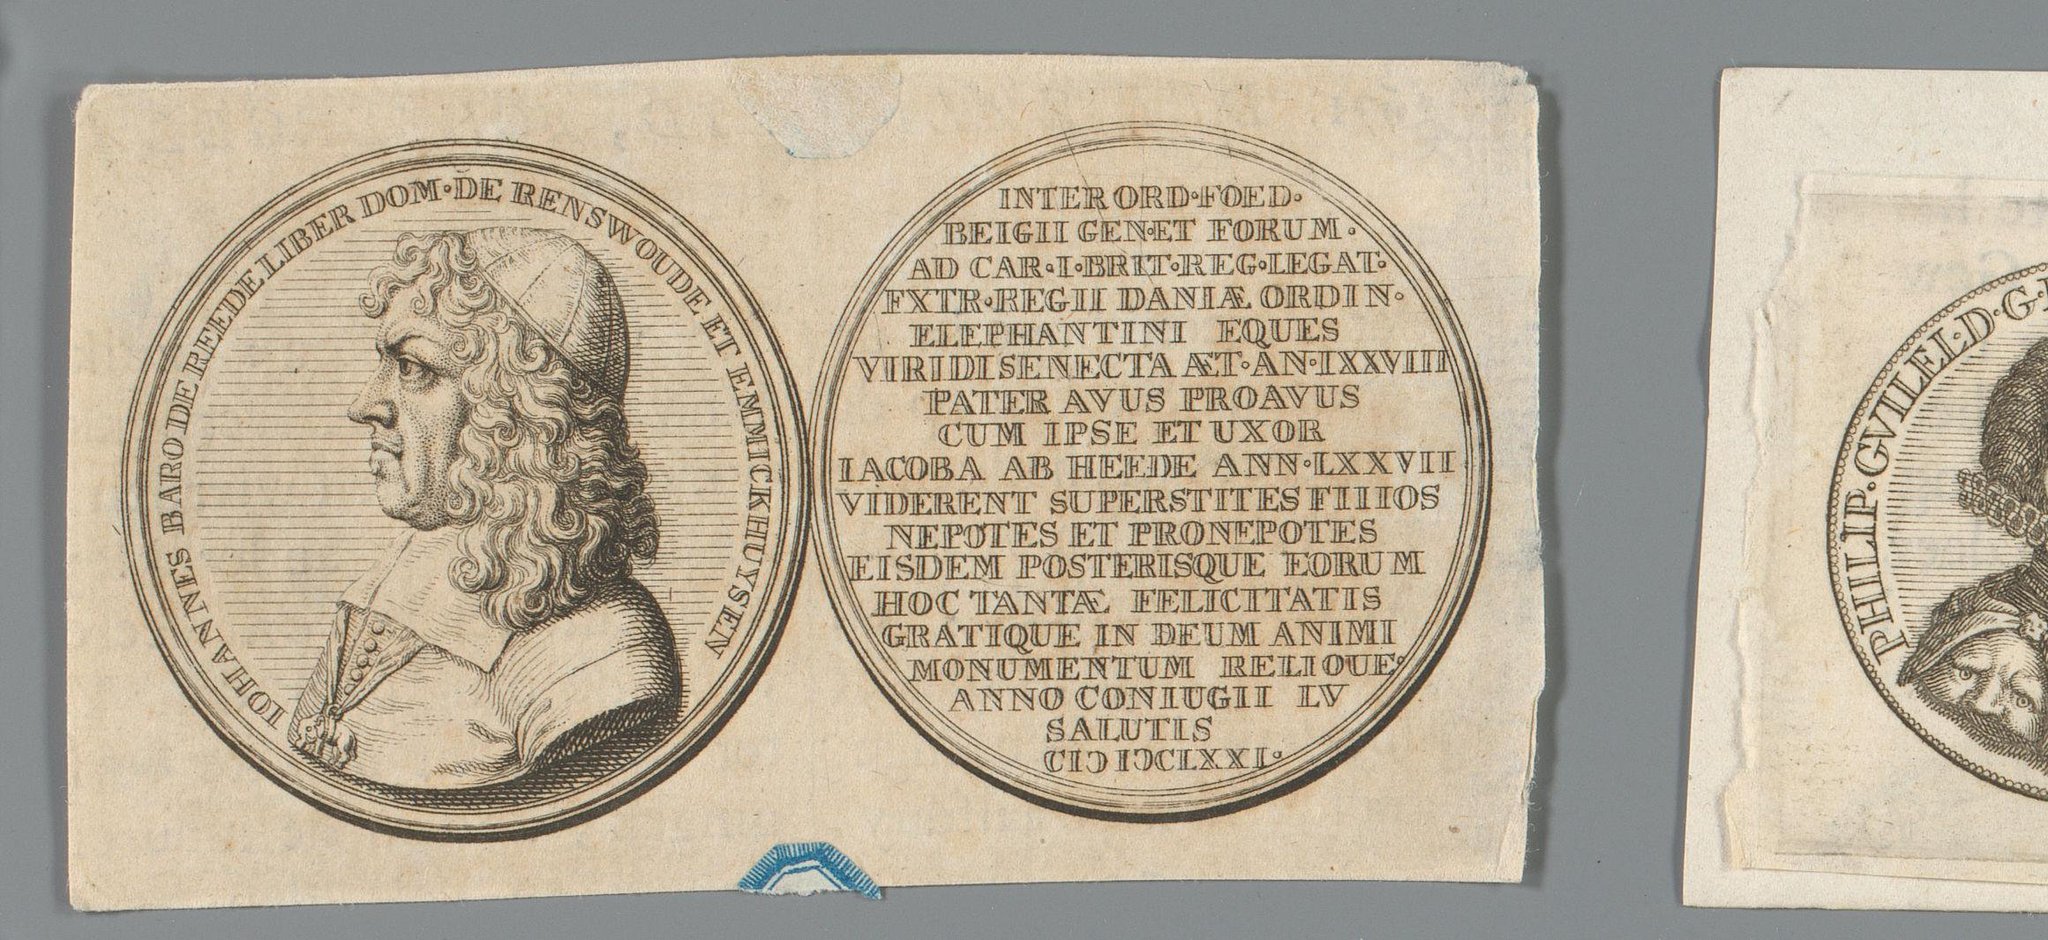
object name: print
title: Voor- en achterzijde van een penning met daarop het portret van Johan baron van Reede van Renswoude en een gedicht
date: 1728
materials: paper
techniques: etching, letterpress printing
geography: the hague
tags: johan baron van reede van renswoude, historical persons, politician, e.g. party leader, coin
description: Prent uit: Loon, Gerard van. Beschryving der Nederlandsche Historipenningen: (...). Den Haag: Christiaan van Lom et al., 1728, dl. 3, p. 131.